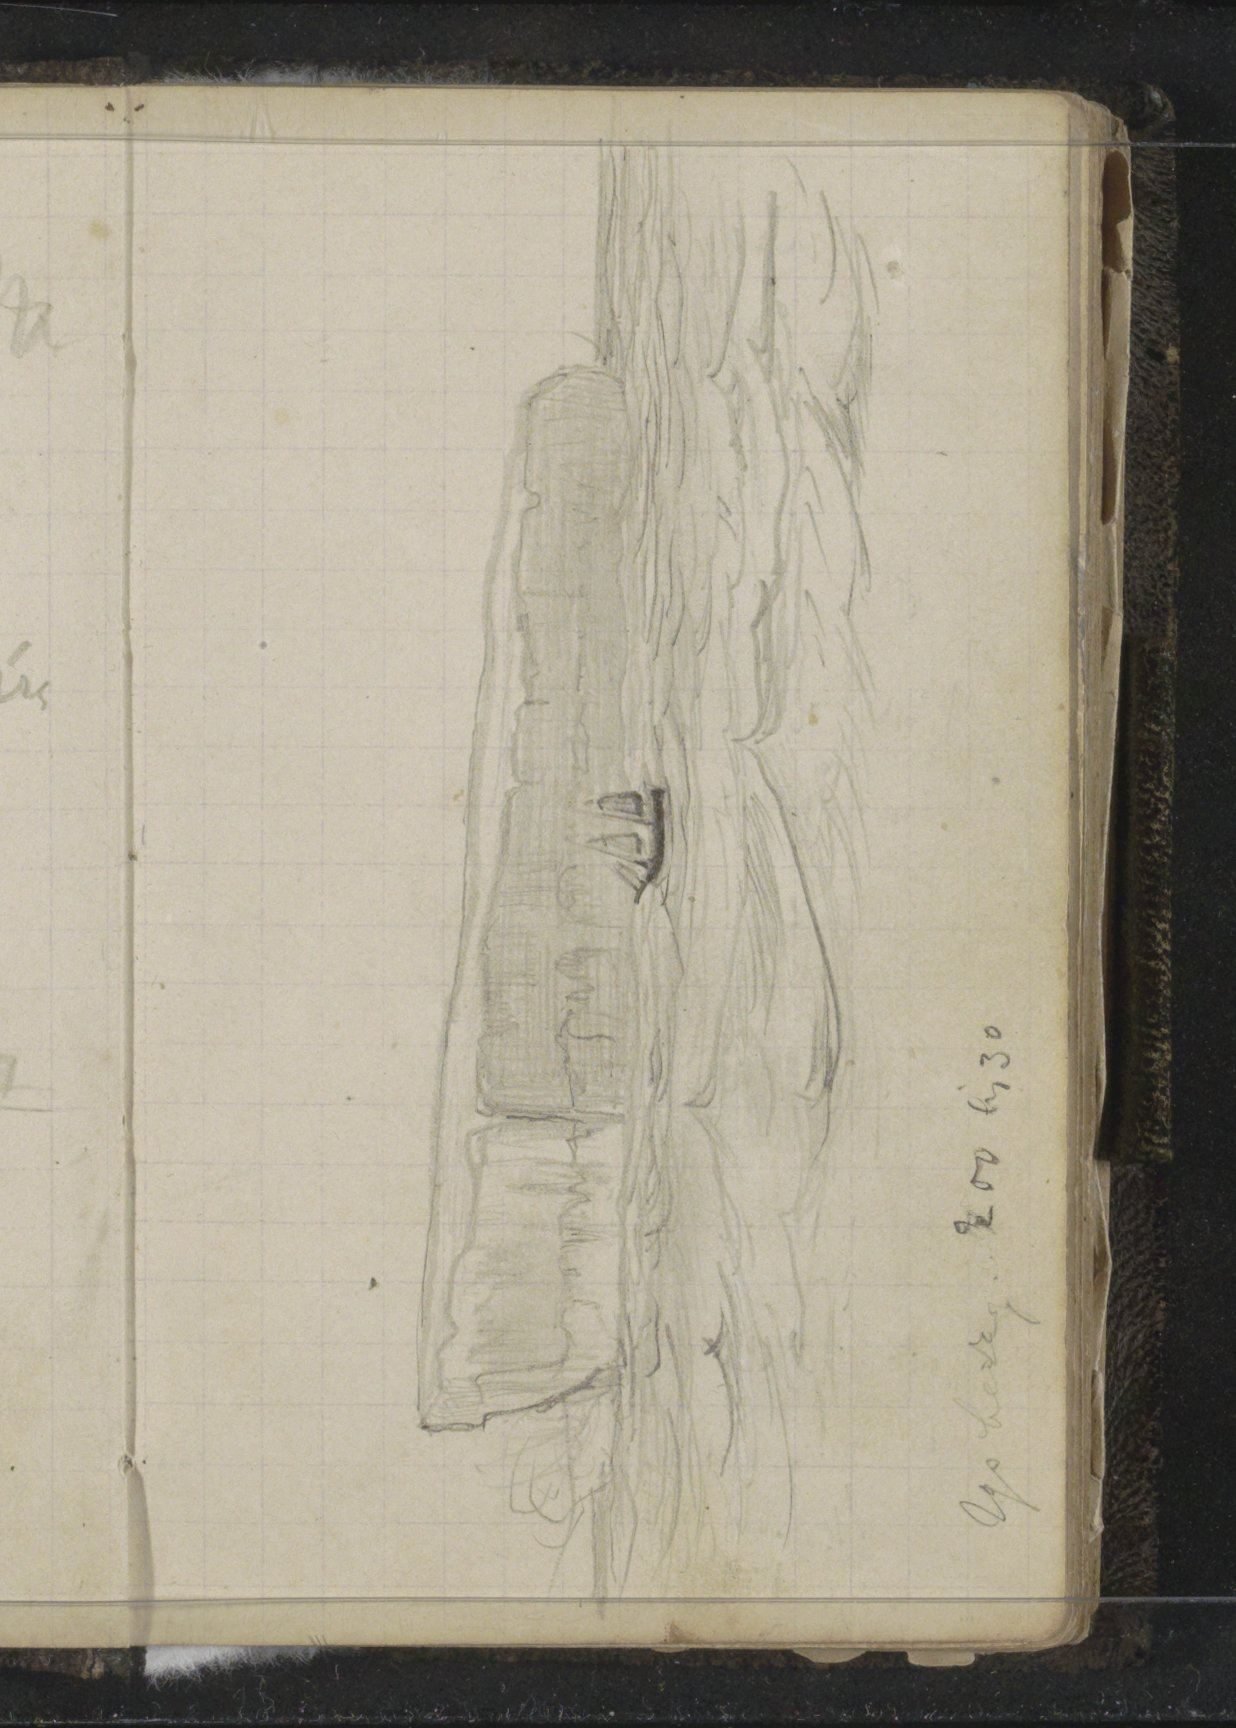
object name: sketchbook leaf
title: Schip voor een ijsschots in de Barentszzee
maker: louis apol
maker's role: draughtsman, painter, print maker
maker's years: 1850-1936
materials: pencil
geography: barentsz sea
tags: iceberg, ships (in general), sea (seascape)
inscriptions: annotation: ‘IJsberg 200 bij 30’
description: Blad 15 recto uit een schetsboek met 110 bladen betekend tijdens de expeditie naar Nova Zembla in 1880.